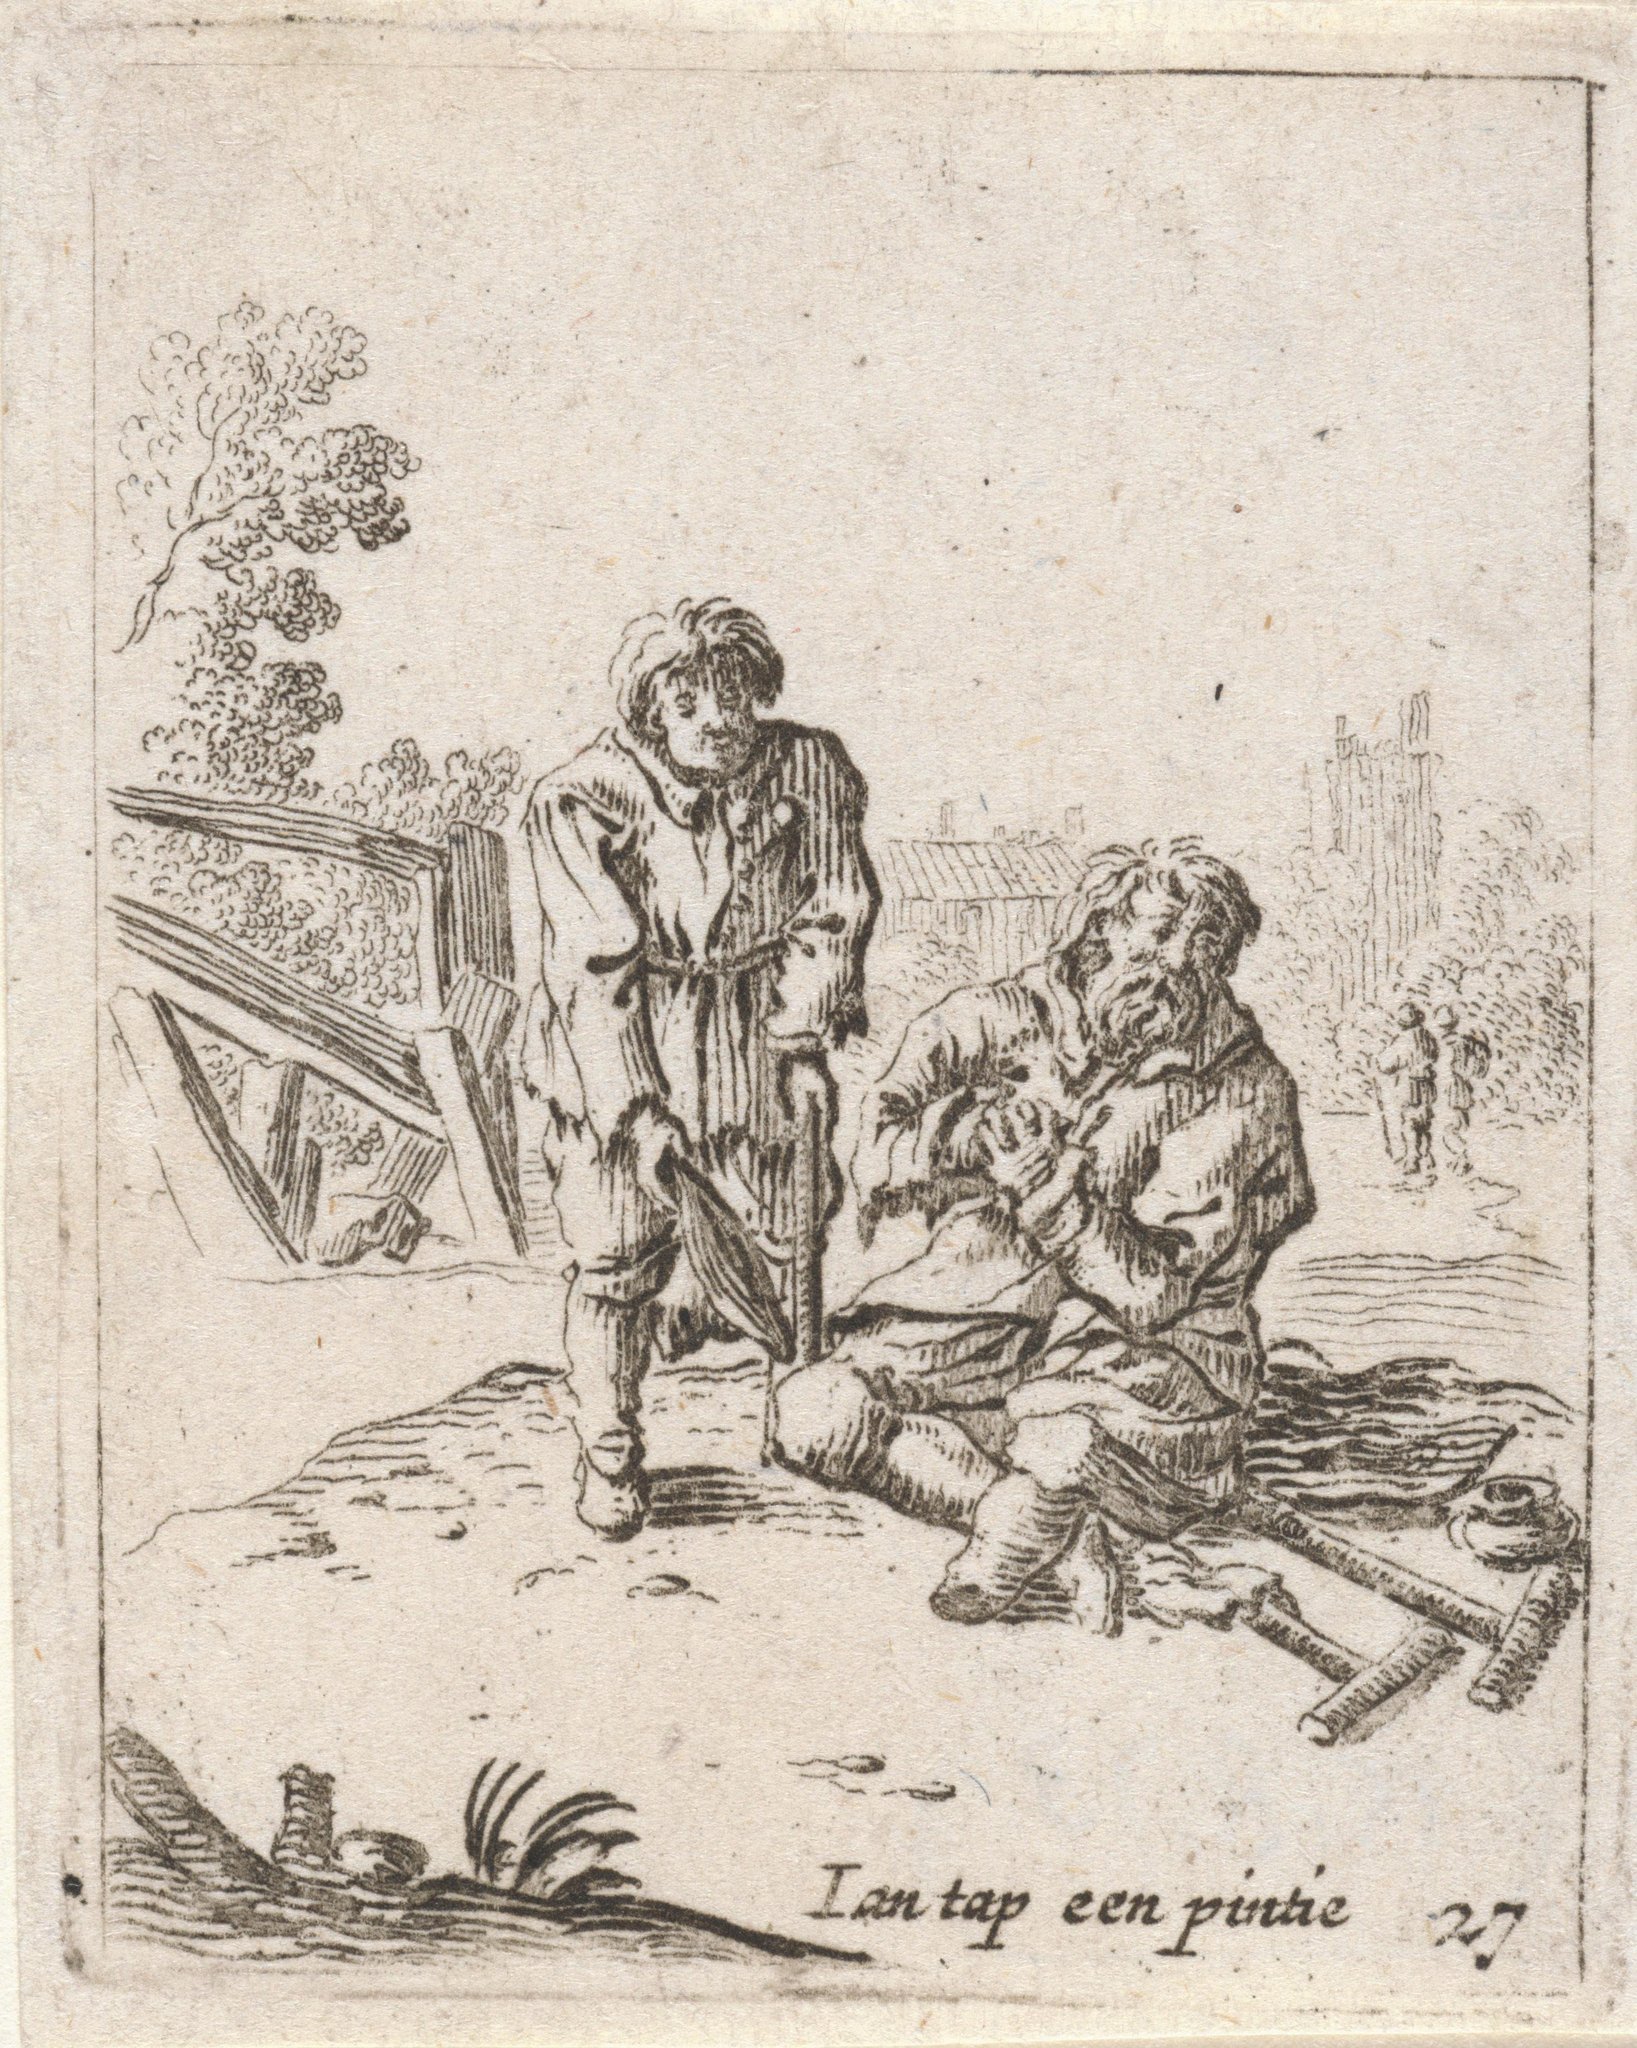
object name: print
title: Ian tap een pintie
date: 1630-1706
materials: paper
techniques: engraving, etching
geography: netherlands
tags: crutches, person with a physical disability, beggar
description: Twee kreupele landlopers bij een hek. De staande man bedelt met zijn hoed bij de zittende man. Op de achtergrond enkele bomen en huizen. De prent maakt deel uit van een serie van 32 prenten met genretaferelen.